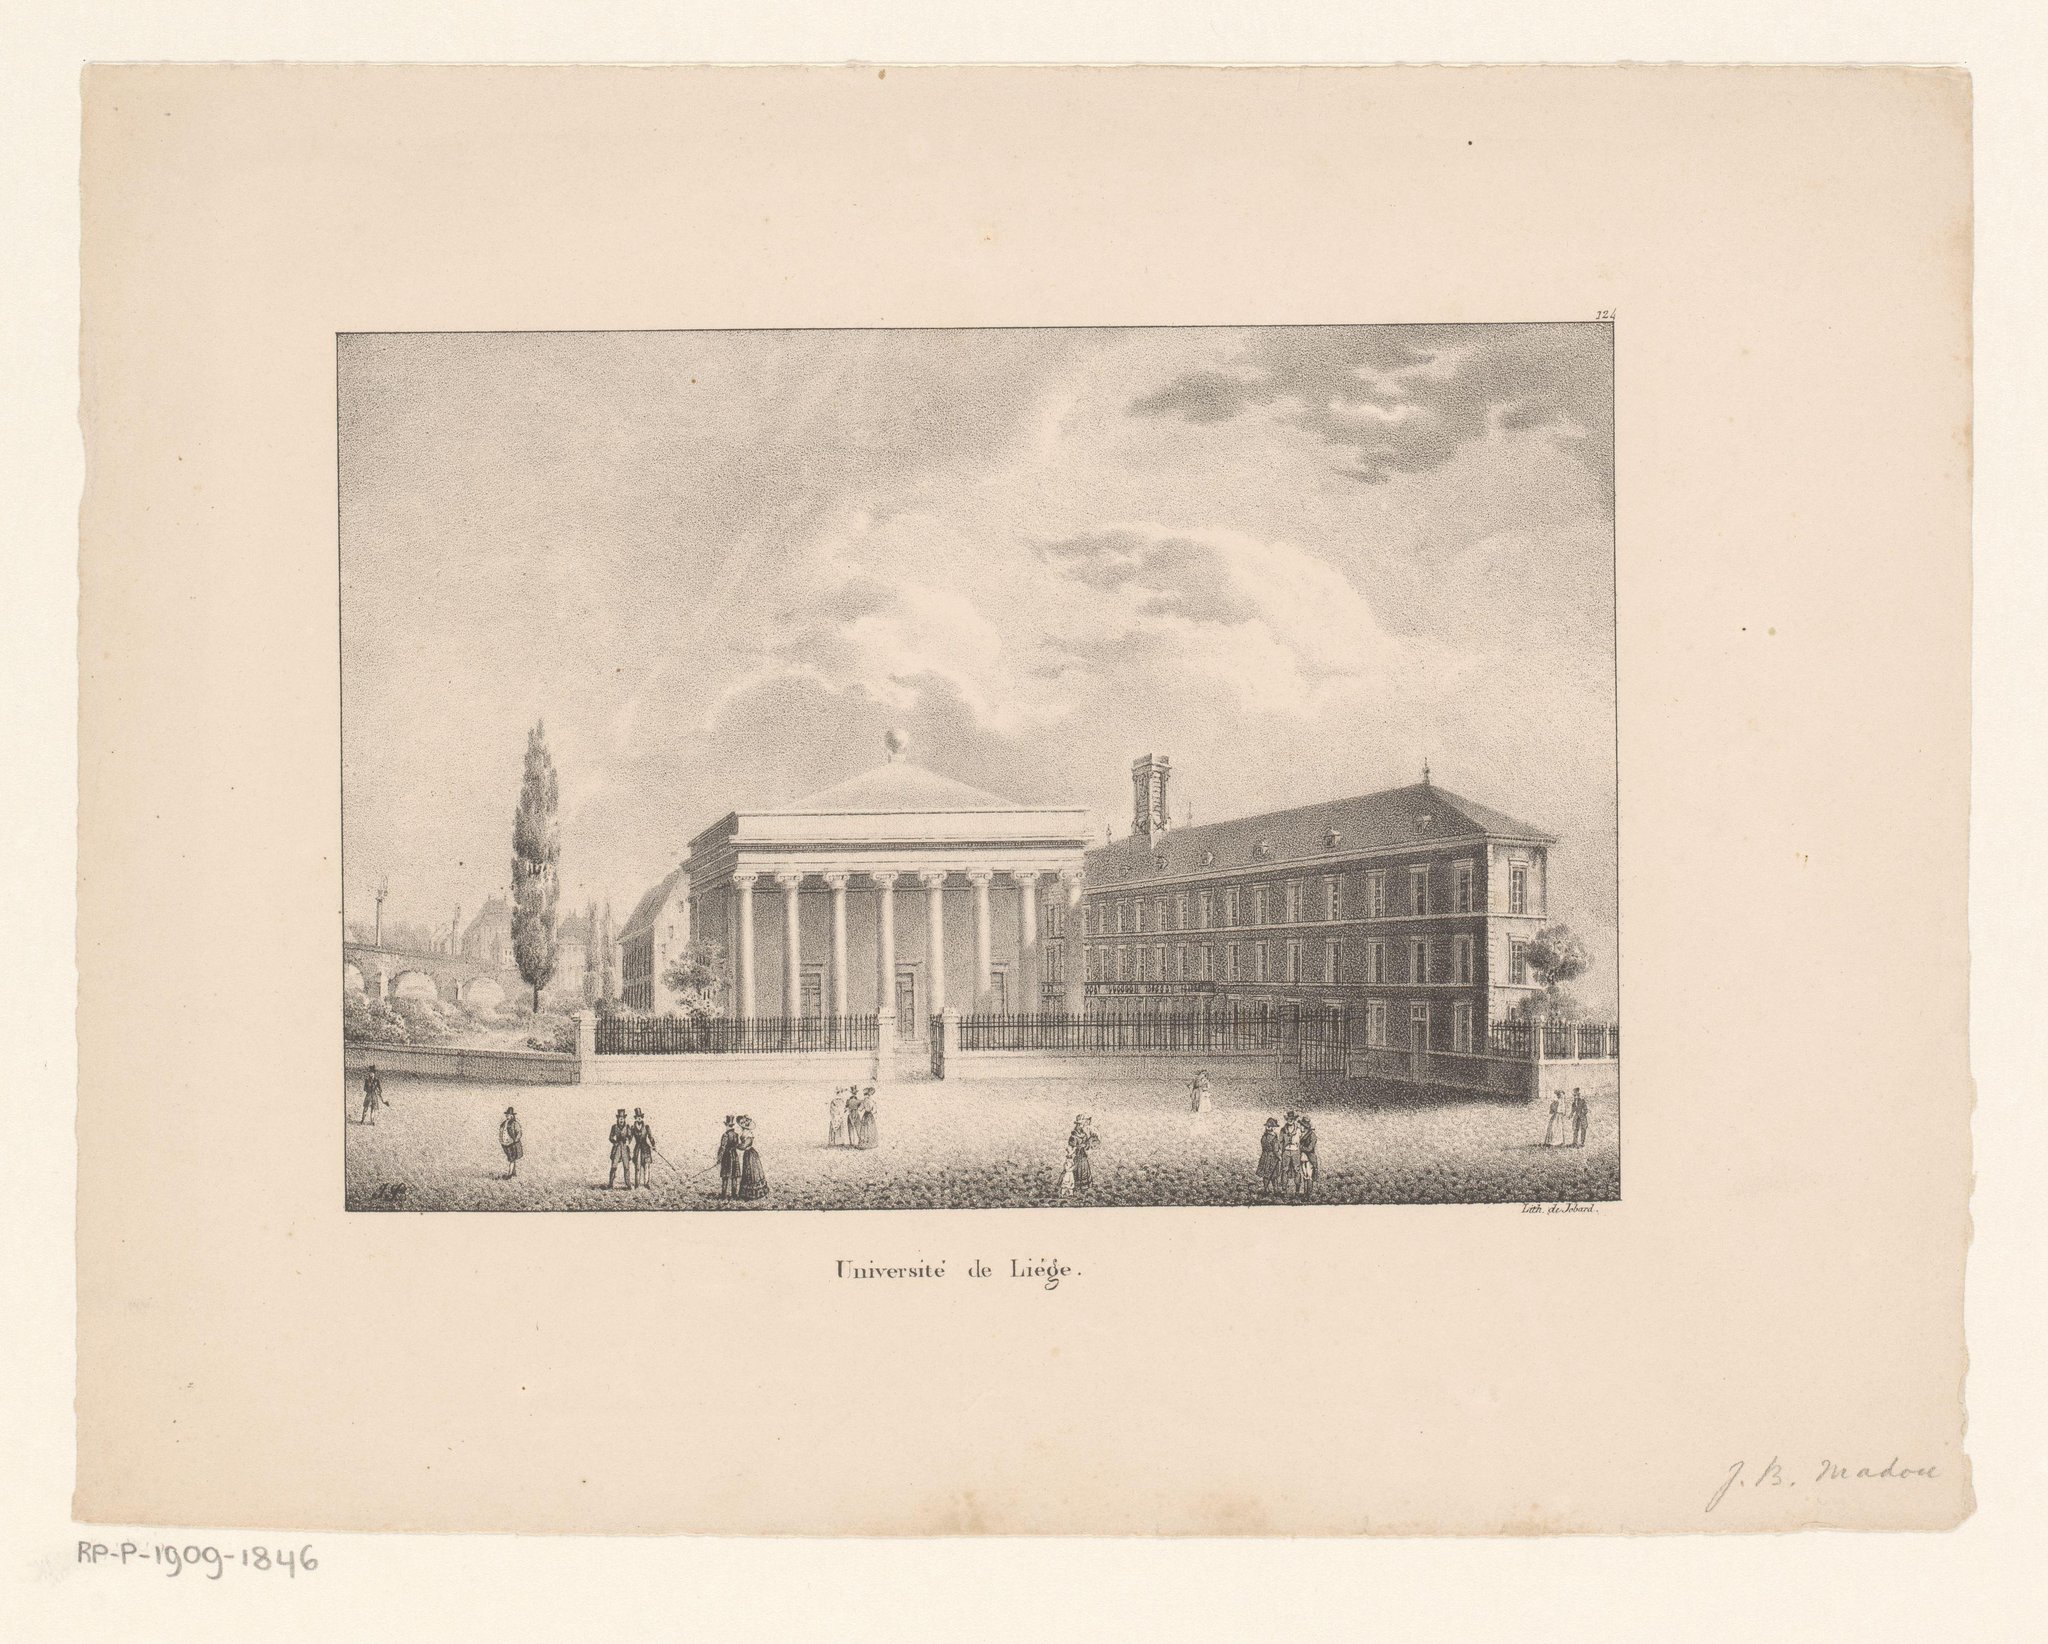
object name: print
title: Gezicht op universiteitsgebouw te Luik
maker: jean baptiste madou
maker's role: draughtsman, painter, print maker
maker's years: 1796-1877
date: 1827-1829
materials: paper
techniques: lithograph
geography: brussels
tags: university building, college, liège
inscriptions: collector's mark: Lugt 2228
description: Prent waarschijnlijk verschenen in: Cloet, J.J. de. Châteaux et monumens des Pays-Bas faisant suite au voyage pittoresque. 2 dln. Brussel: Jobard frères, [1827-1829], dl. onbekend, nr. 124.